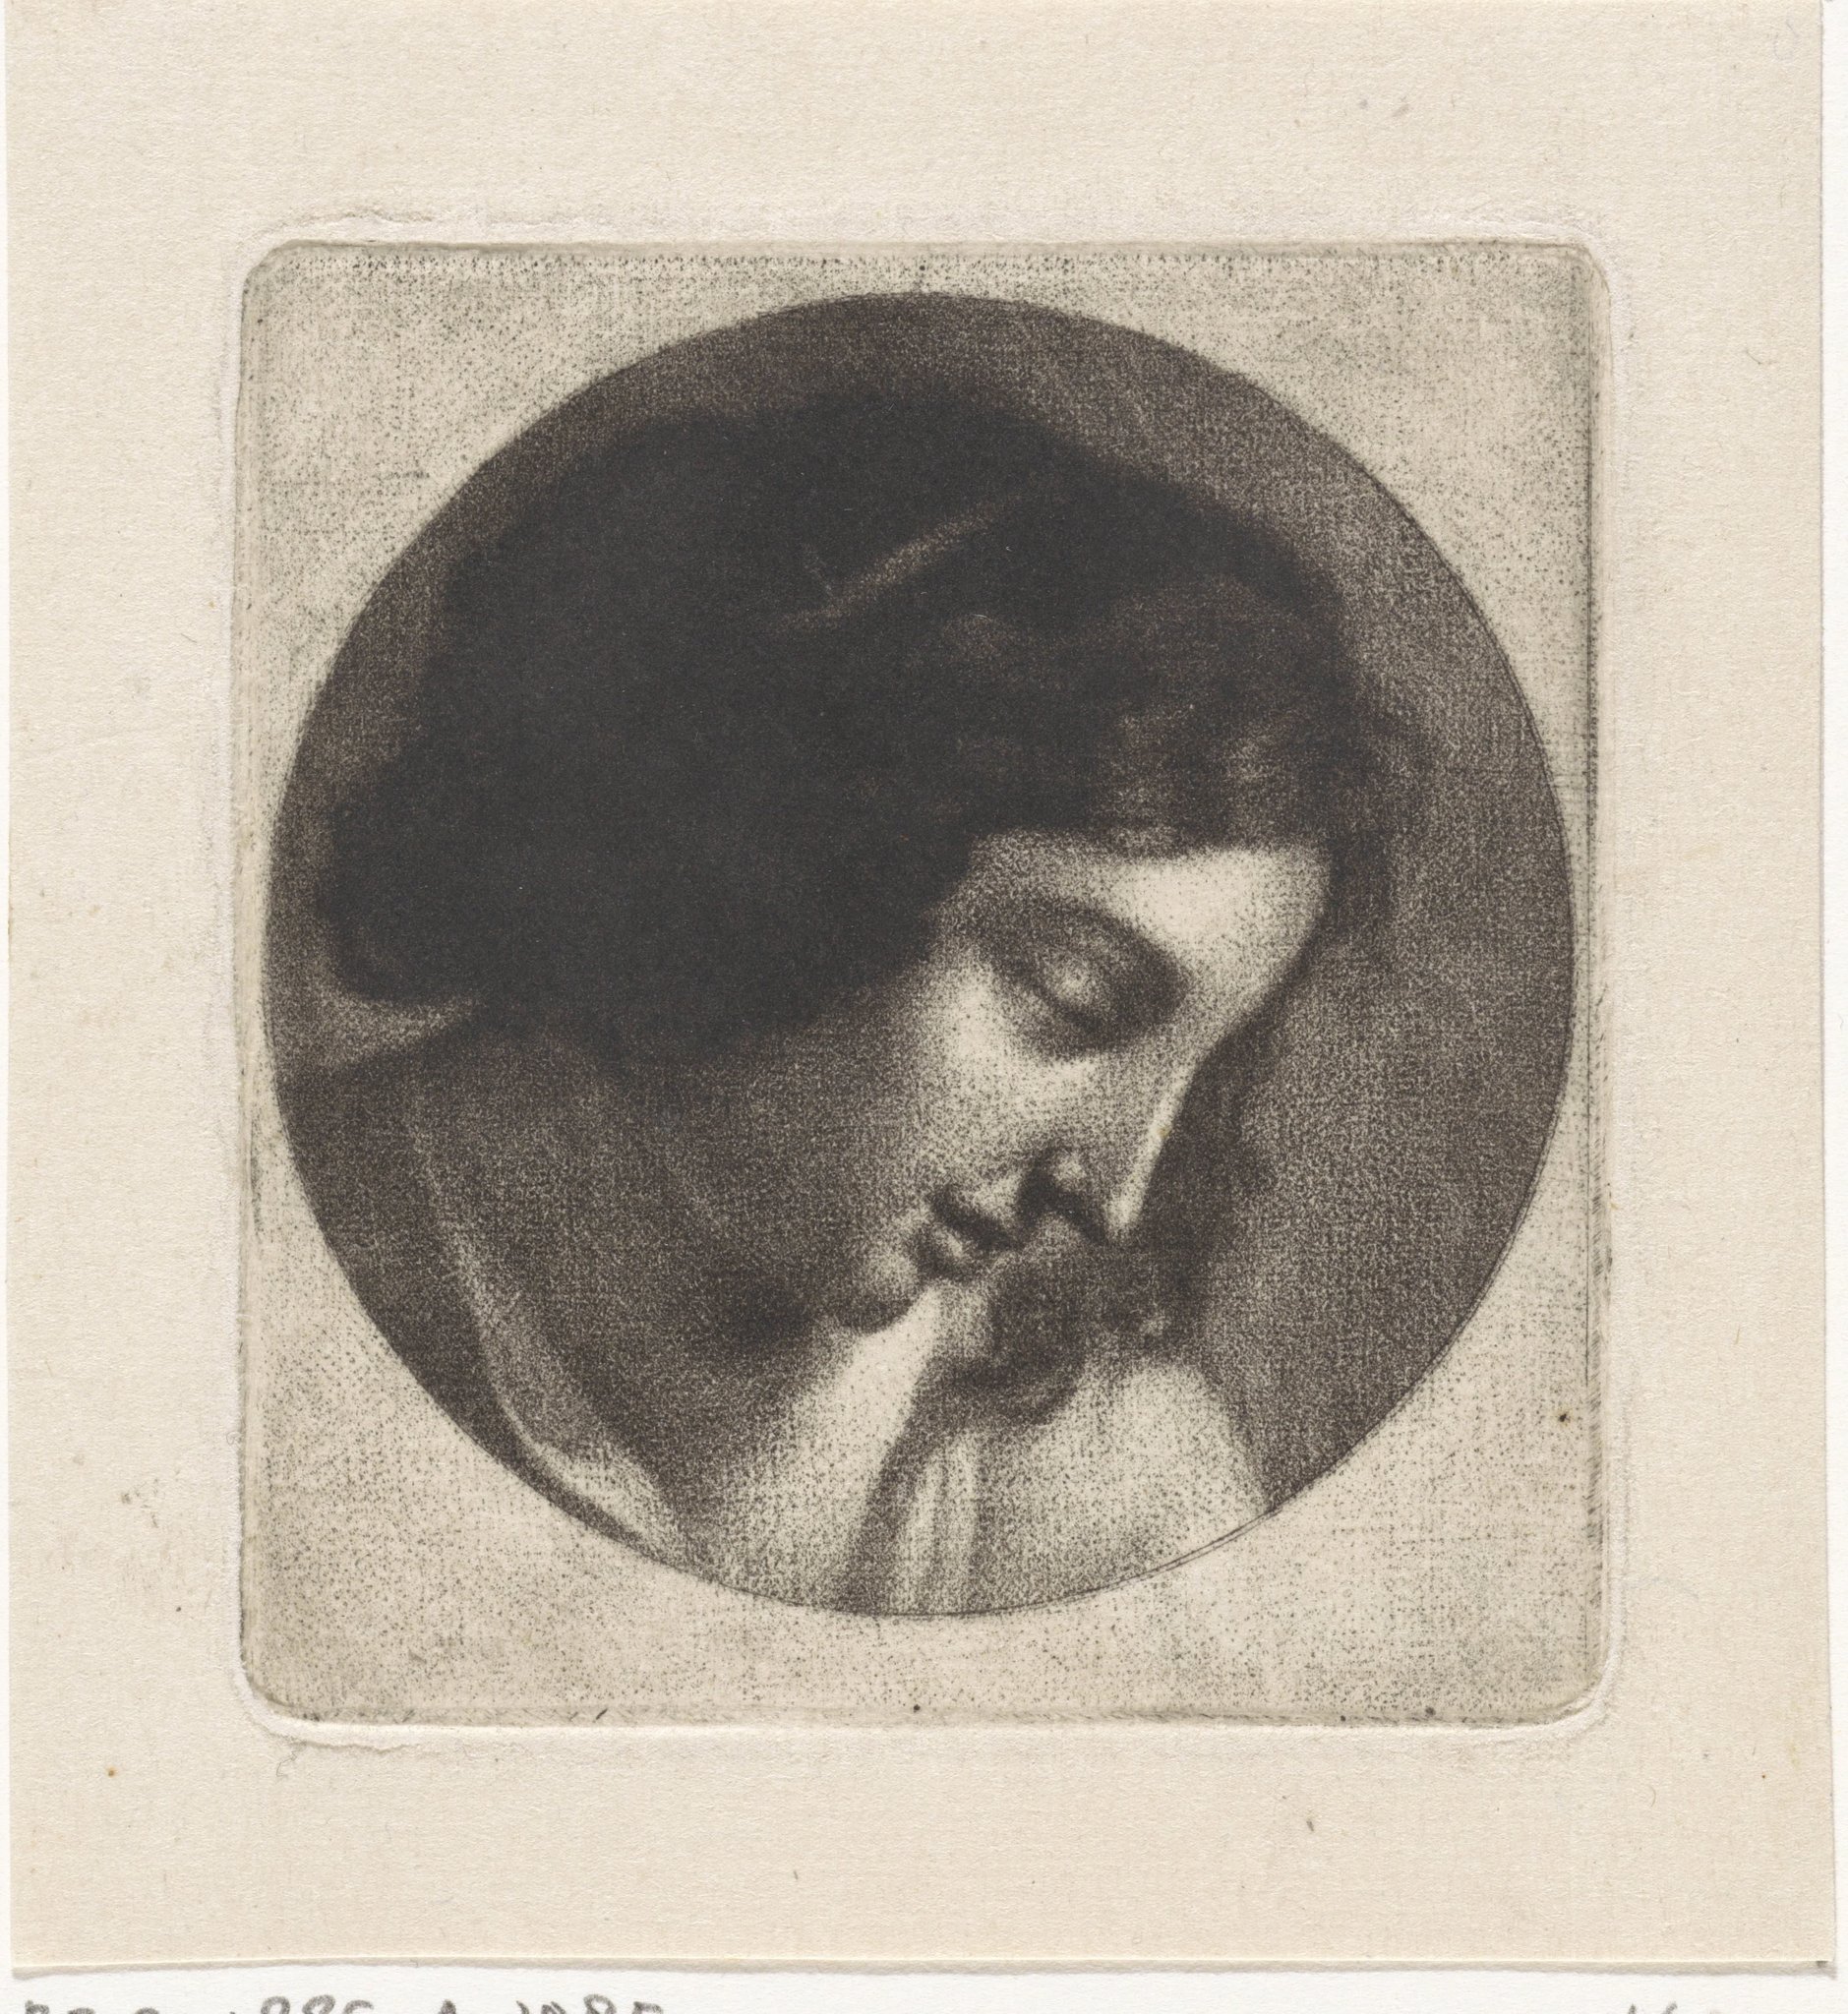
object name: print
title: Buste van een jonge vrouw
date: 1652-1690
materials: paper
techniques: mezzotint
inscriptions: collector's mark: Lugt 2228